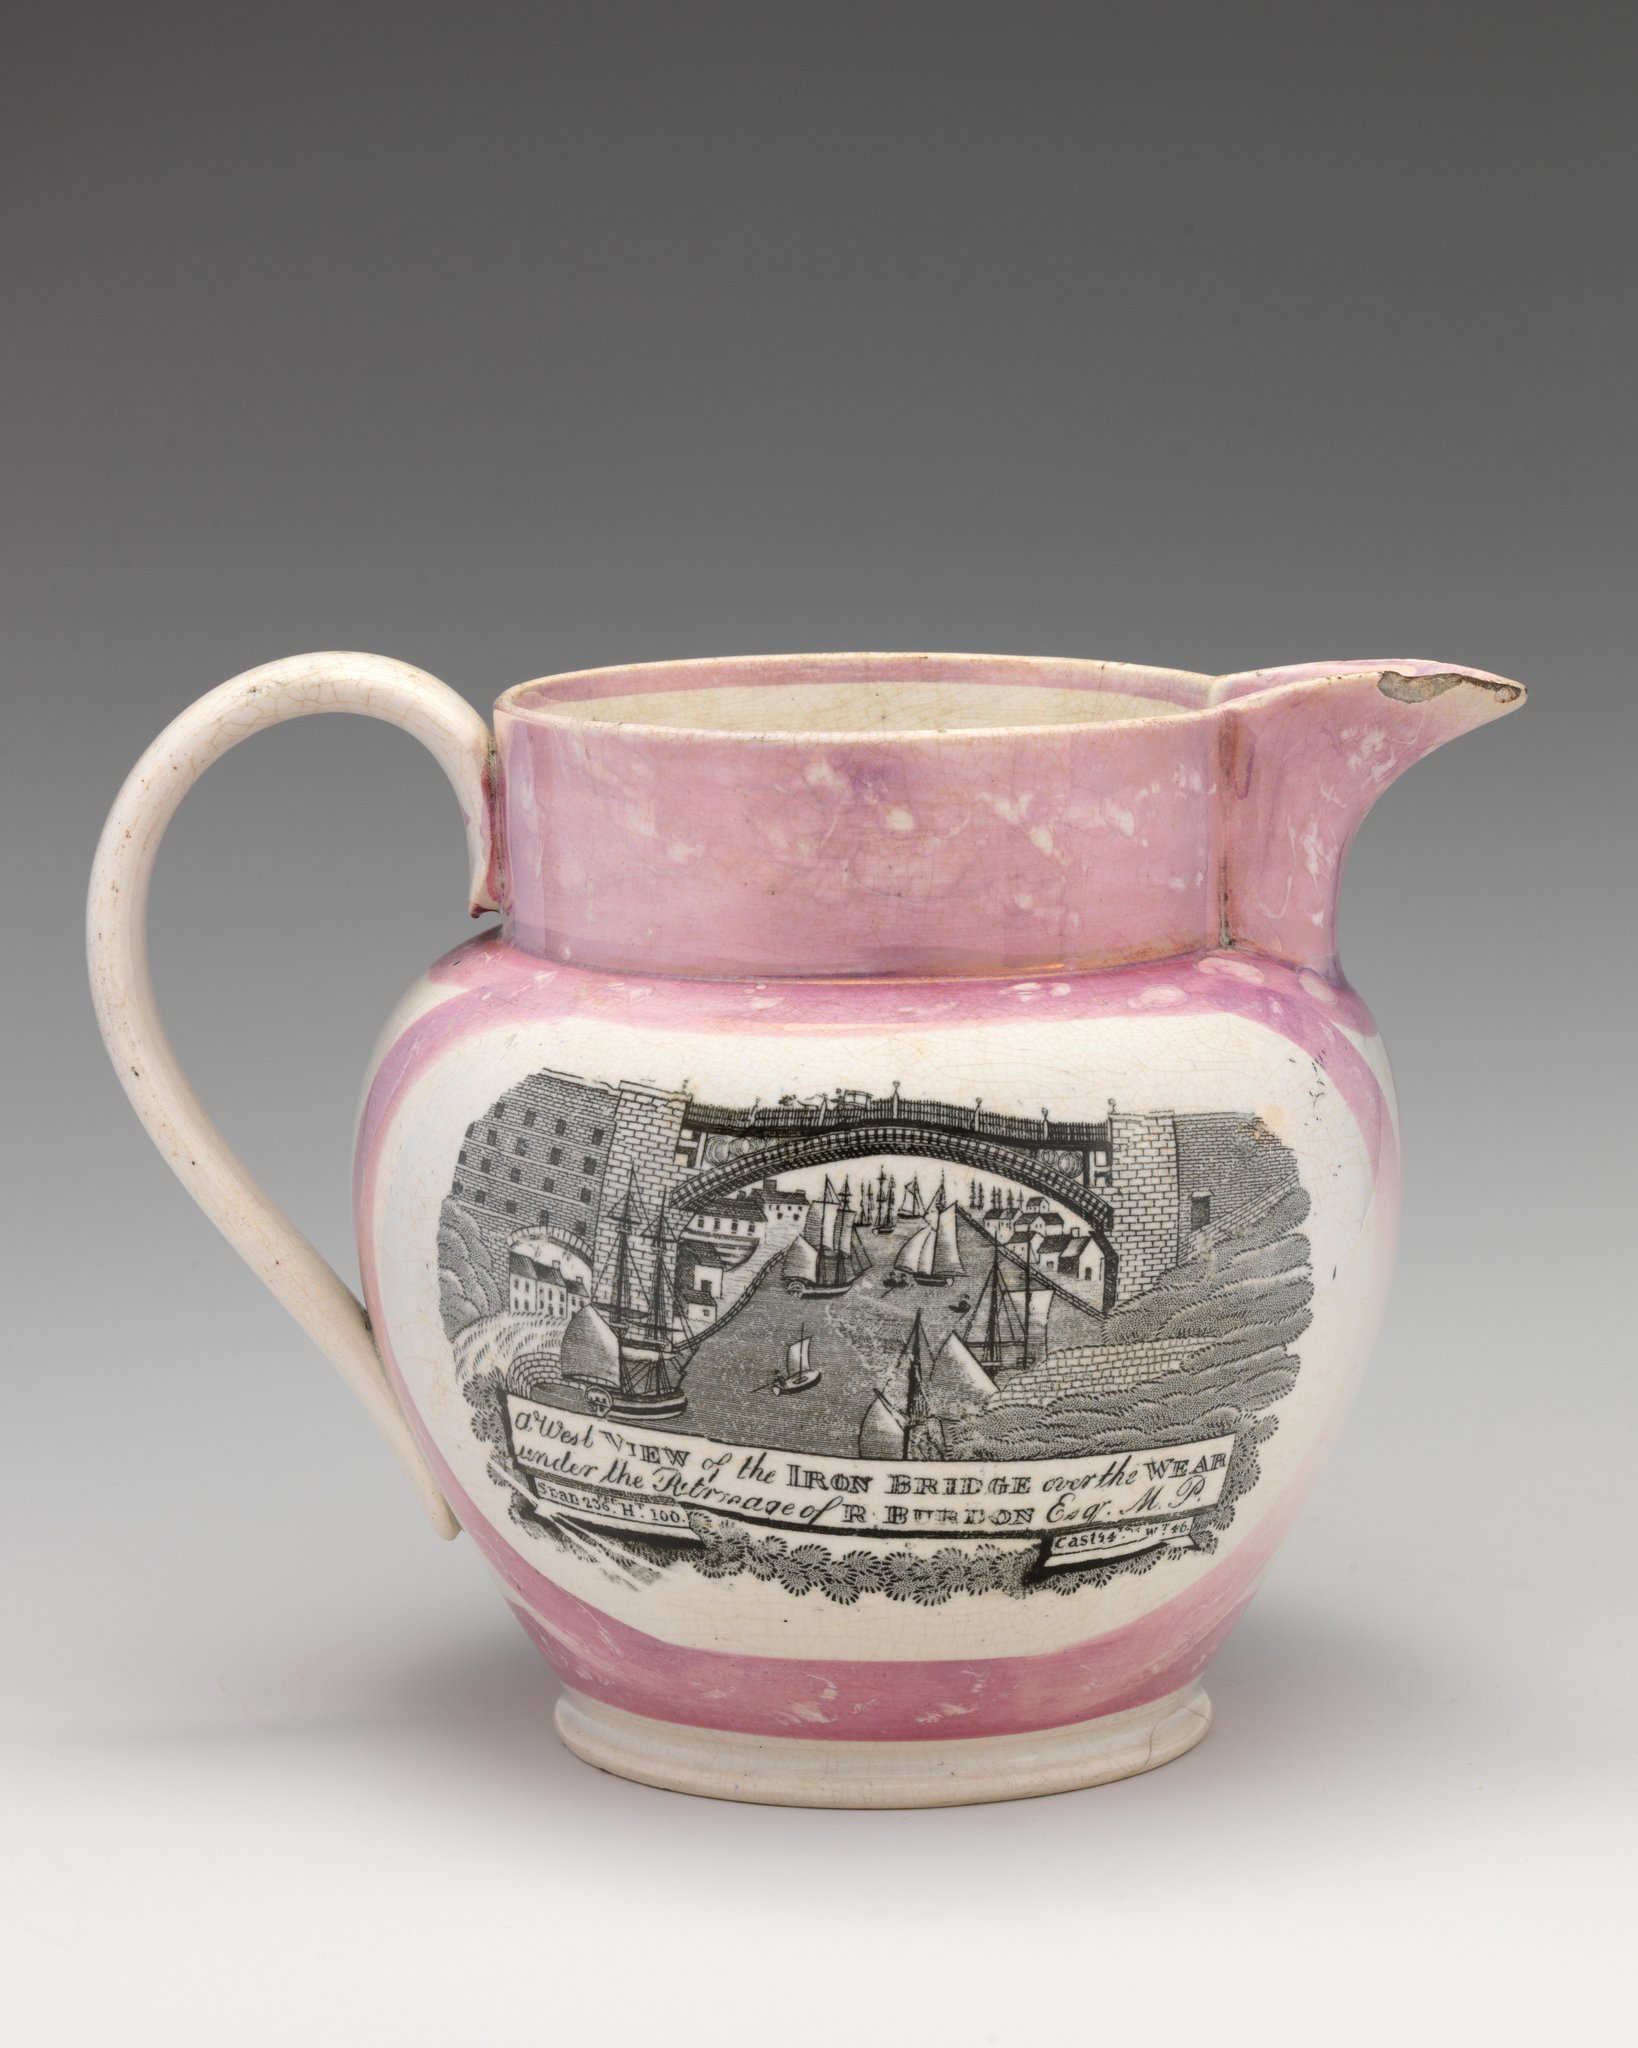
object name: jug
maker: phillips and co.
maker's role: factory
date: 1801-1833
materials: pottery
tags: bridges,boats